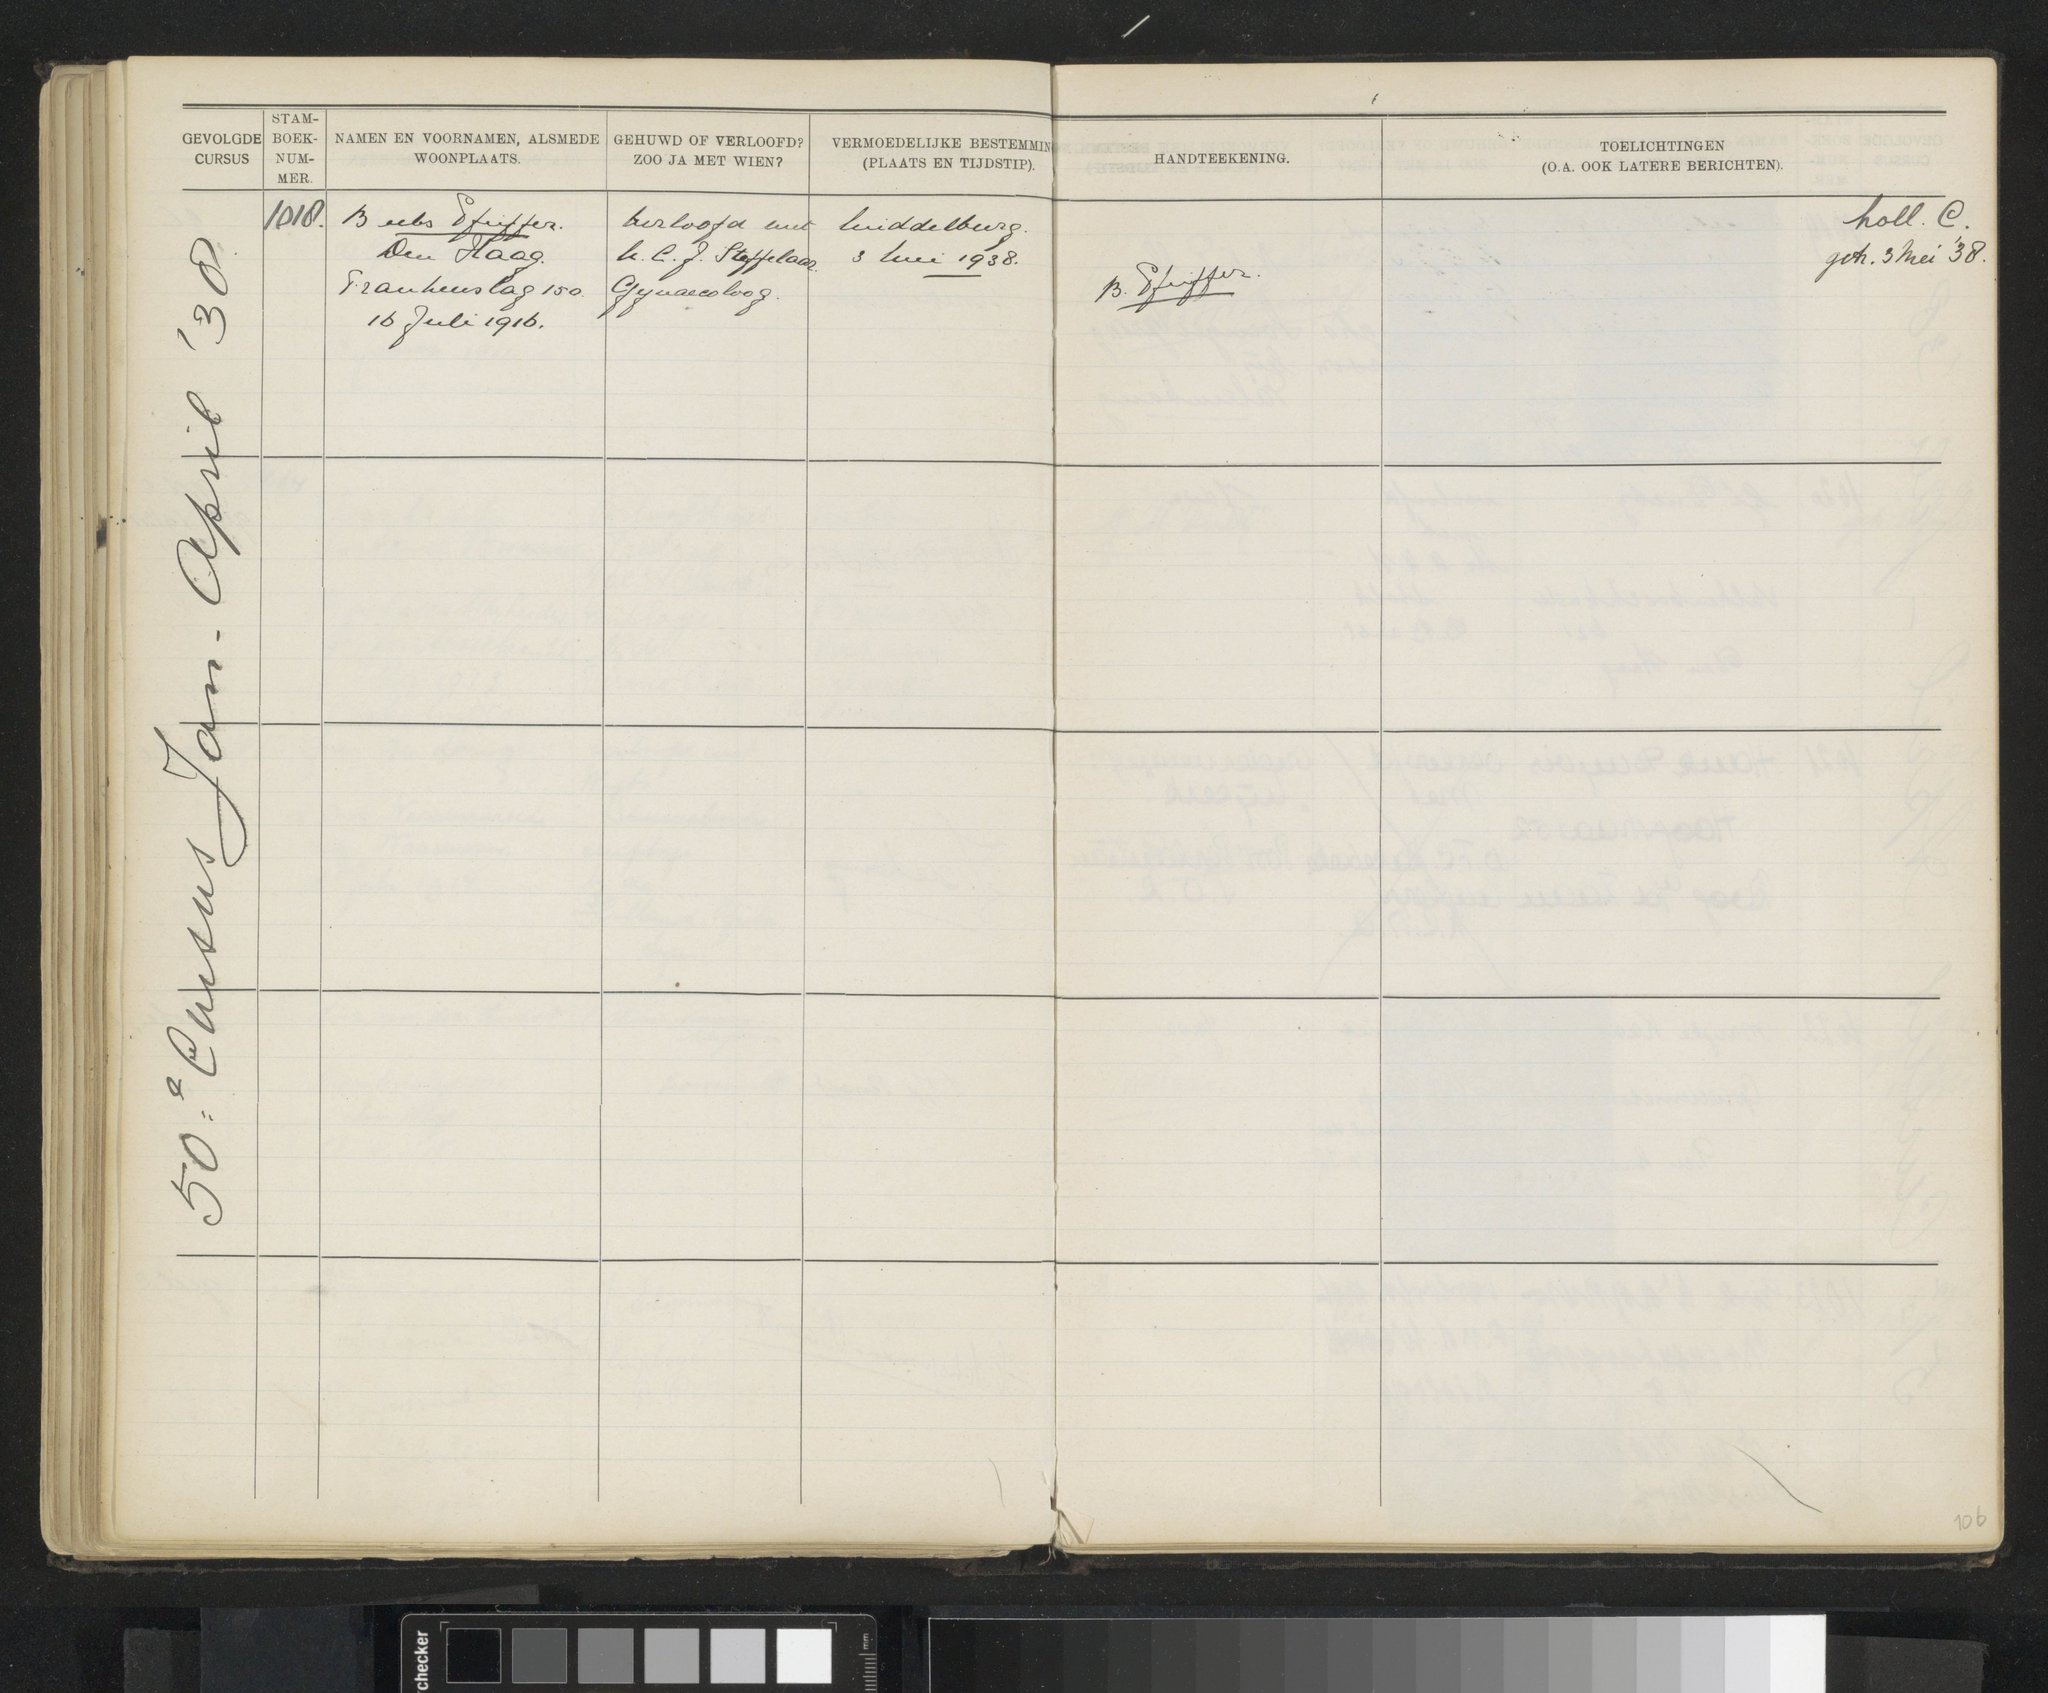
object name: album leaf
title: Blad 106 uit Stamboek van de leerlingen der Koloniale School voor Meisjes en Vrouwen te 's-Gravenhage deel II (1930-1949)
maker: Anonymous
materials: paper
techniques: printing, writing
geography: the hague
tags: further education (+ pupil), further education, the hague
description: Twee pagina's met gegevens van een deelnemer aan de 50e driemaandelijkse cursus van januari tot april 1938, stamboeknummer 1018. Onderdeel van Stamboek van de leerlingen der Koloniale School voor Meisjes en Vrouwen te 's-Gravenhage deel II (1930-1949).